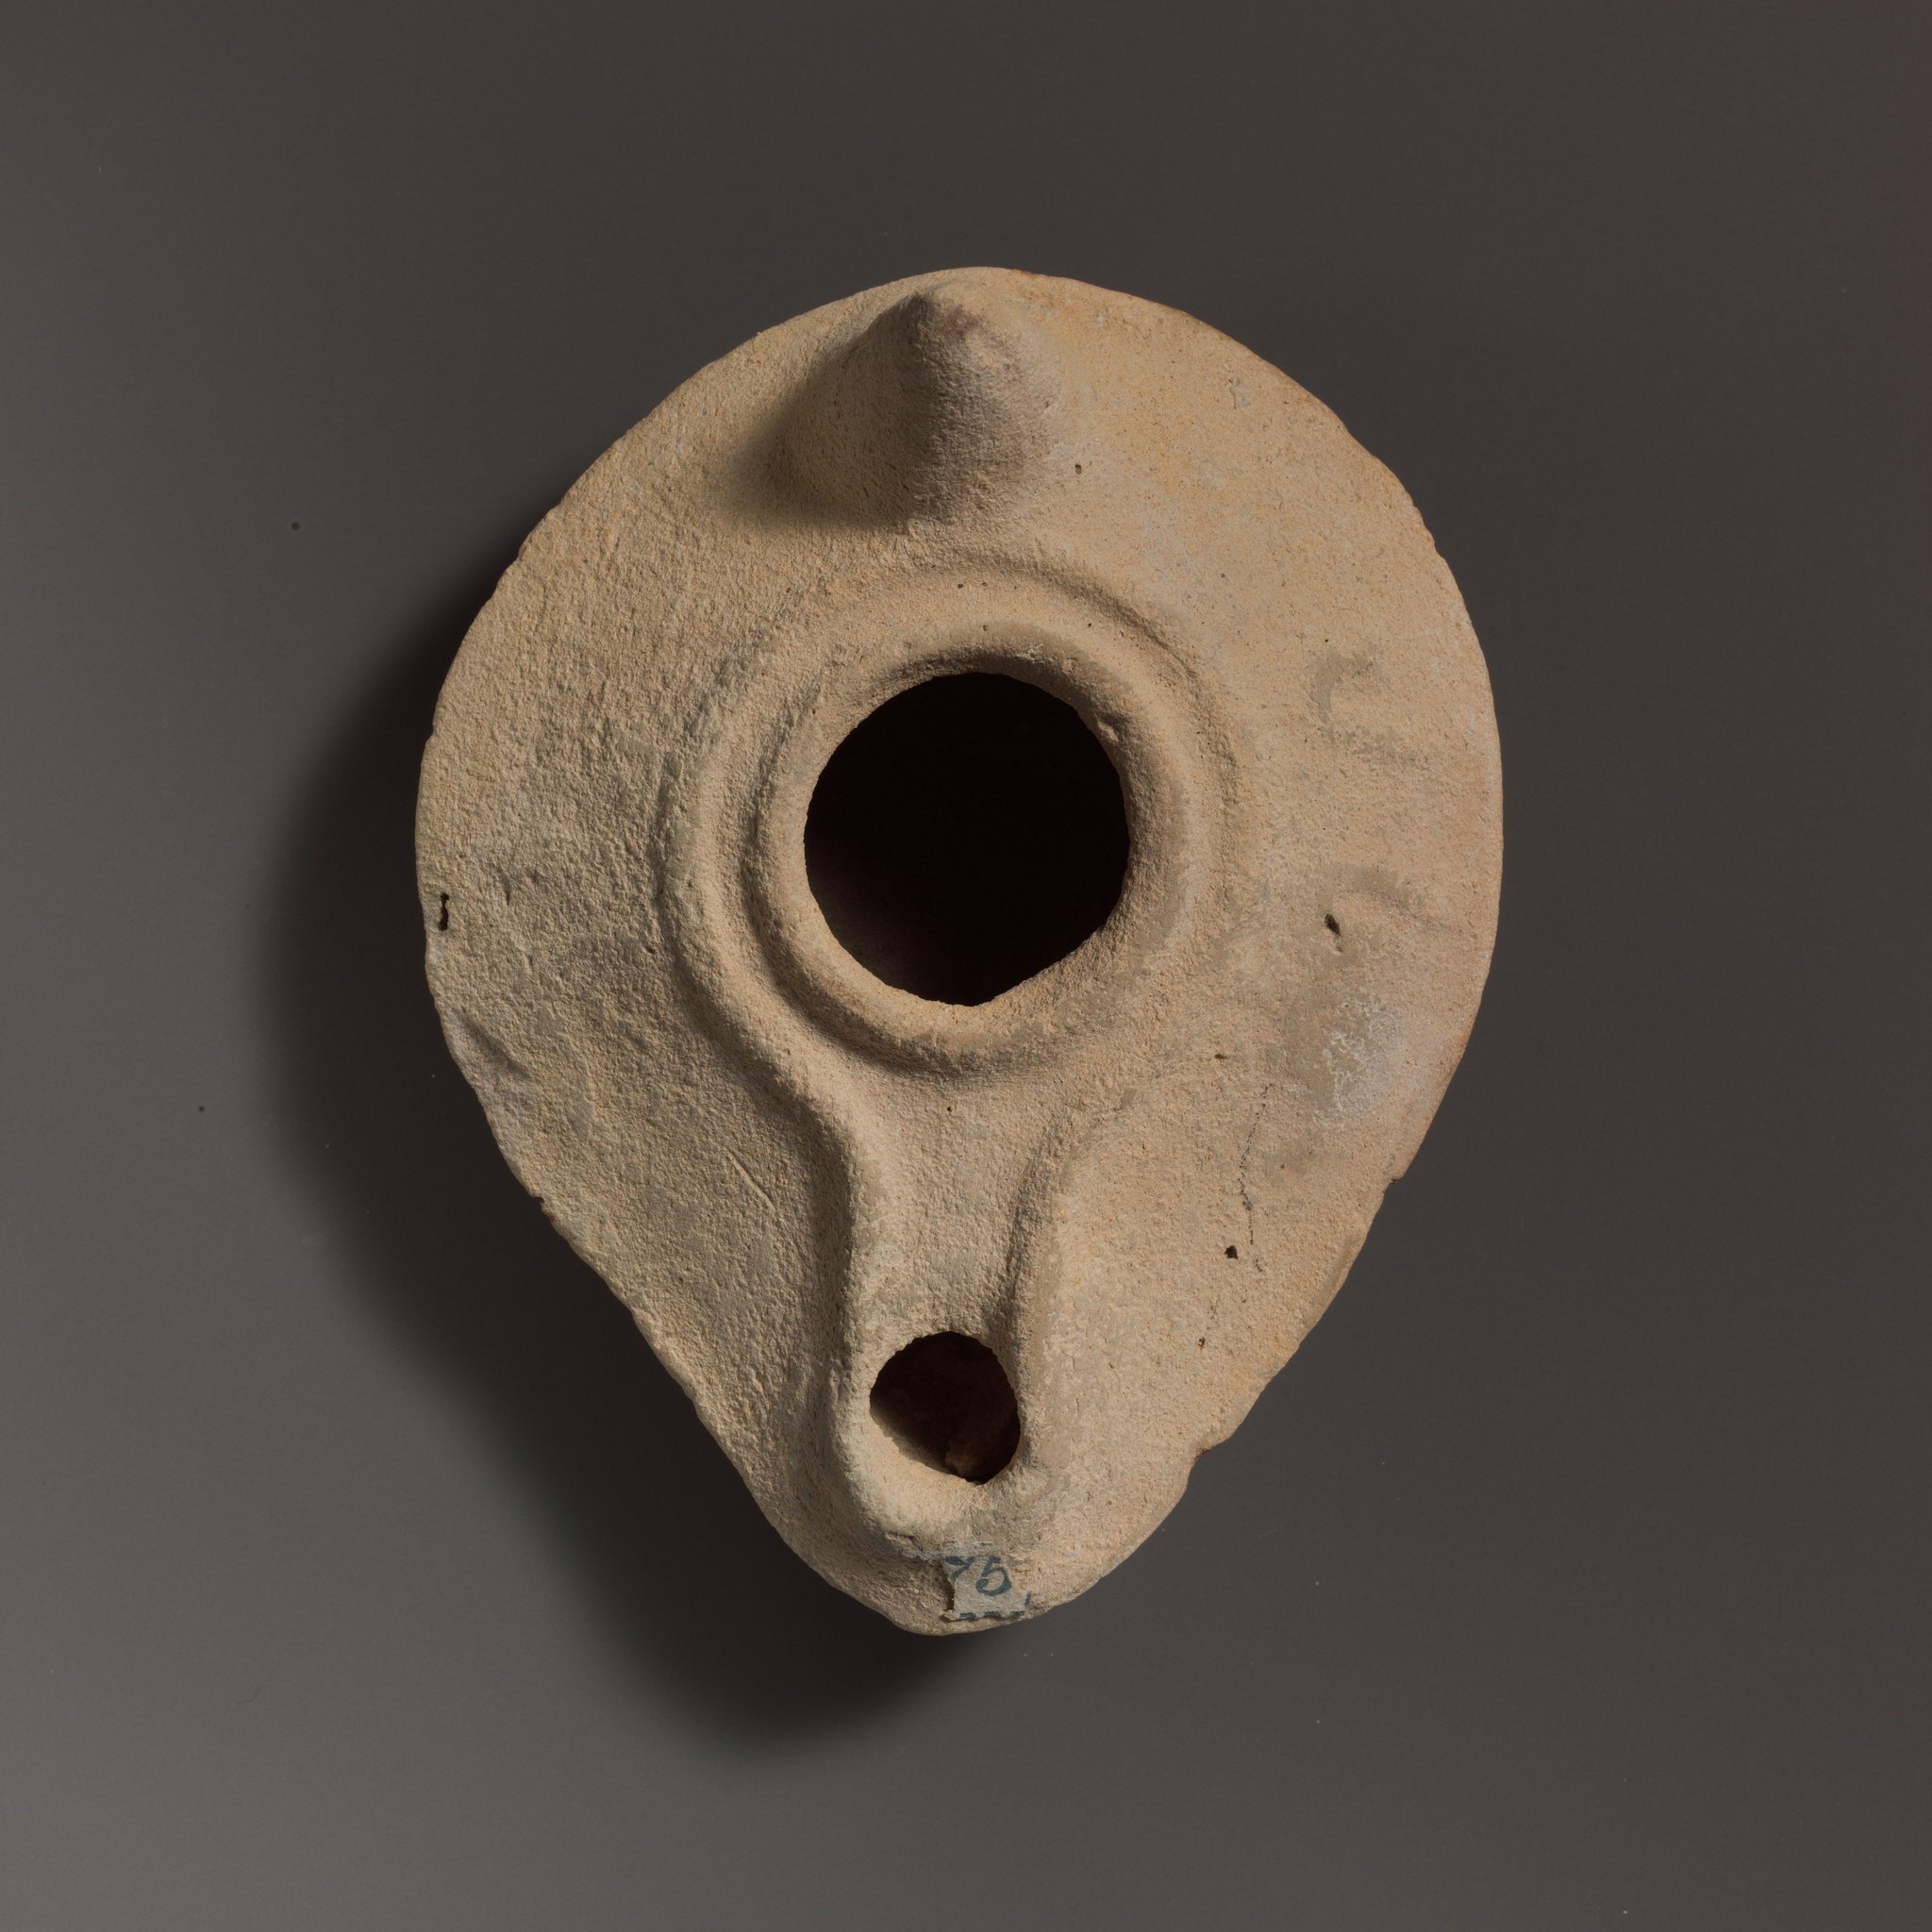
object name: lamp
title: Terracotta oil lamp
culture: roman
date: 601-700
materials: terracotta